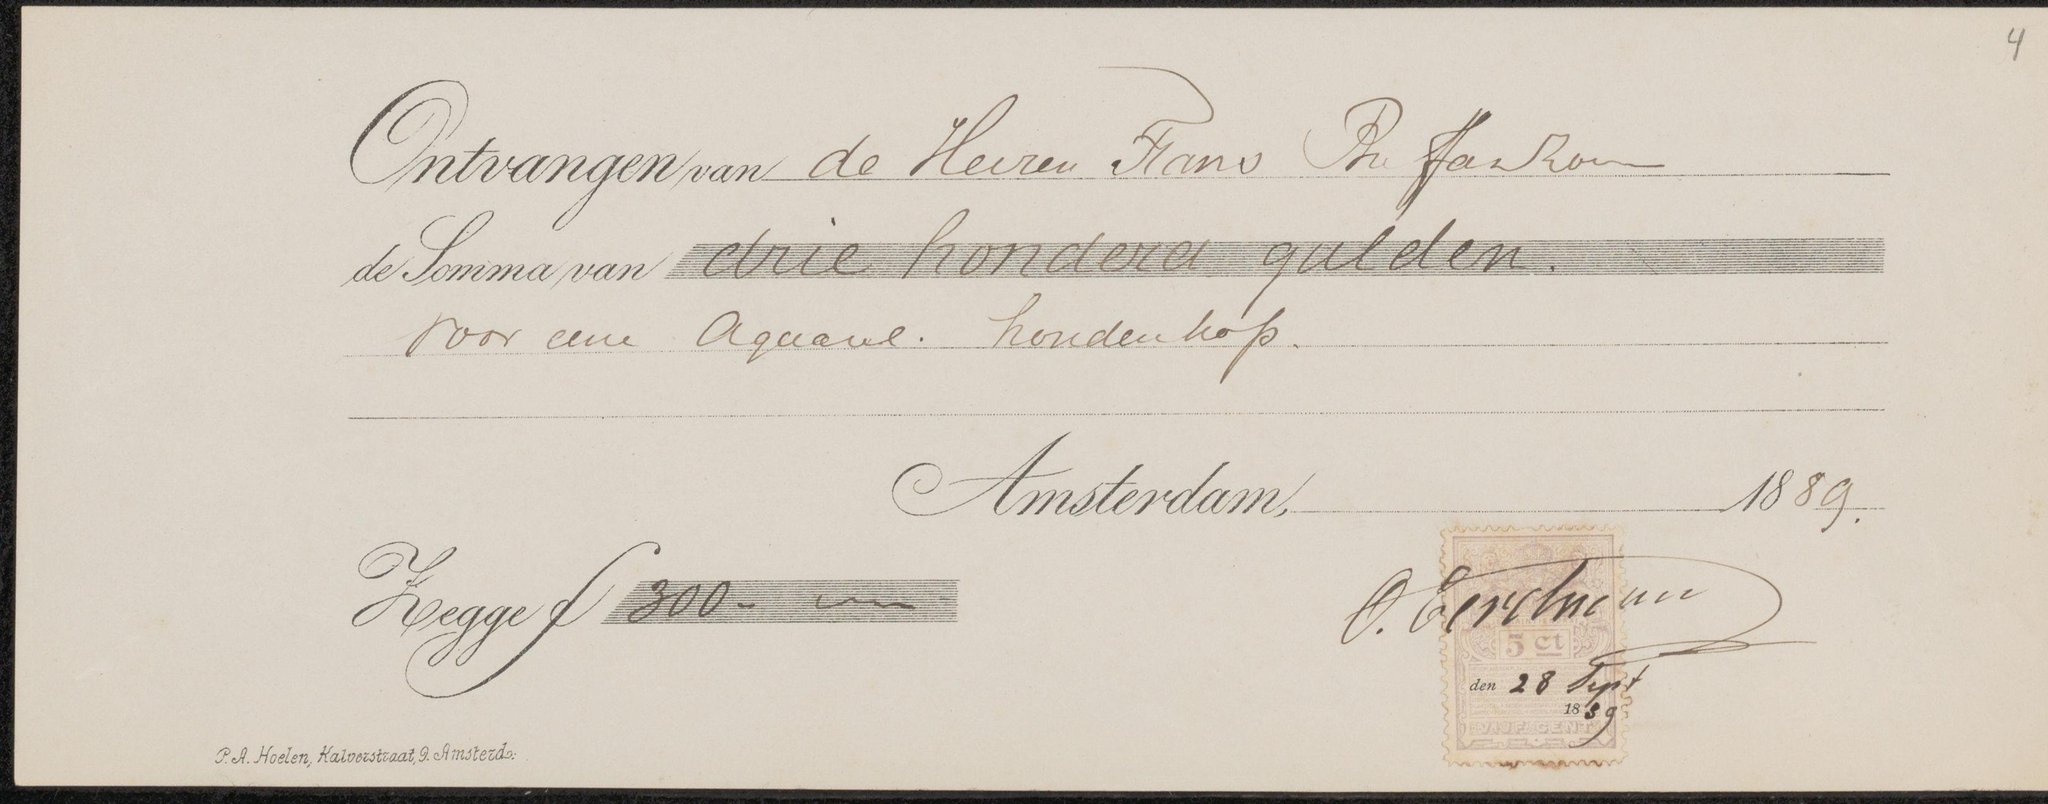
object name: ontvangstbewijs, kwitantie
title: Kwitantie voor Otto Eerelman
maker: otto eerelman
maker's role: draughtsman, painter, print maker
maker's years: 1839-1926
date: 1889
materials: ink, paper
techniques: pen, printing, writing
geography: amsterdam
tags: painter, print maker, draughtsman, otto eerelman, drawing, money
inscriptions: collector's mark: Lugt 2233